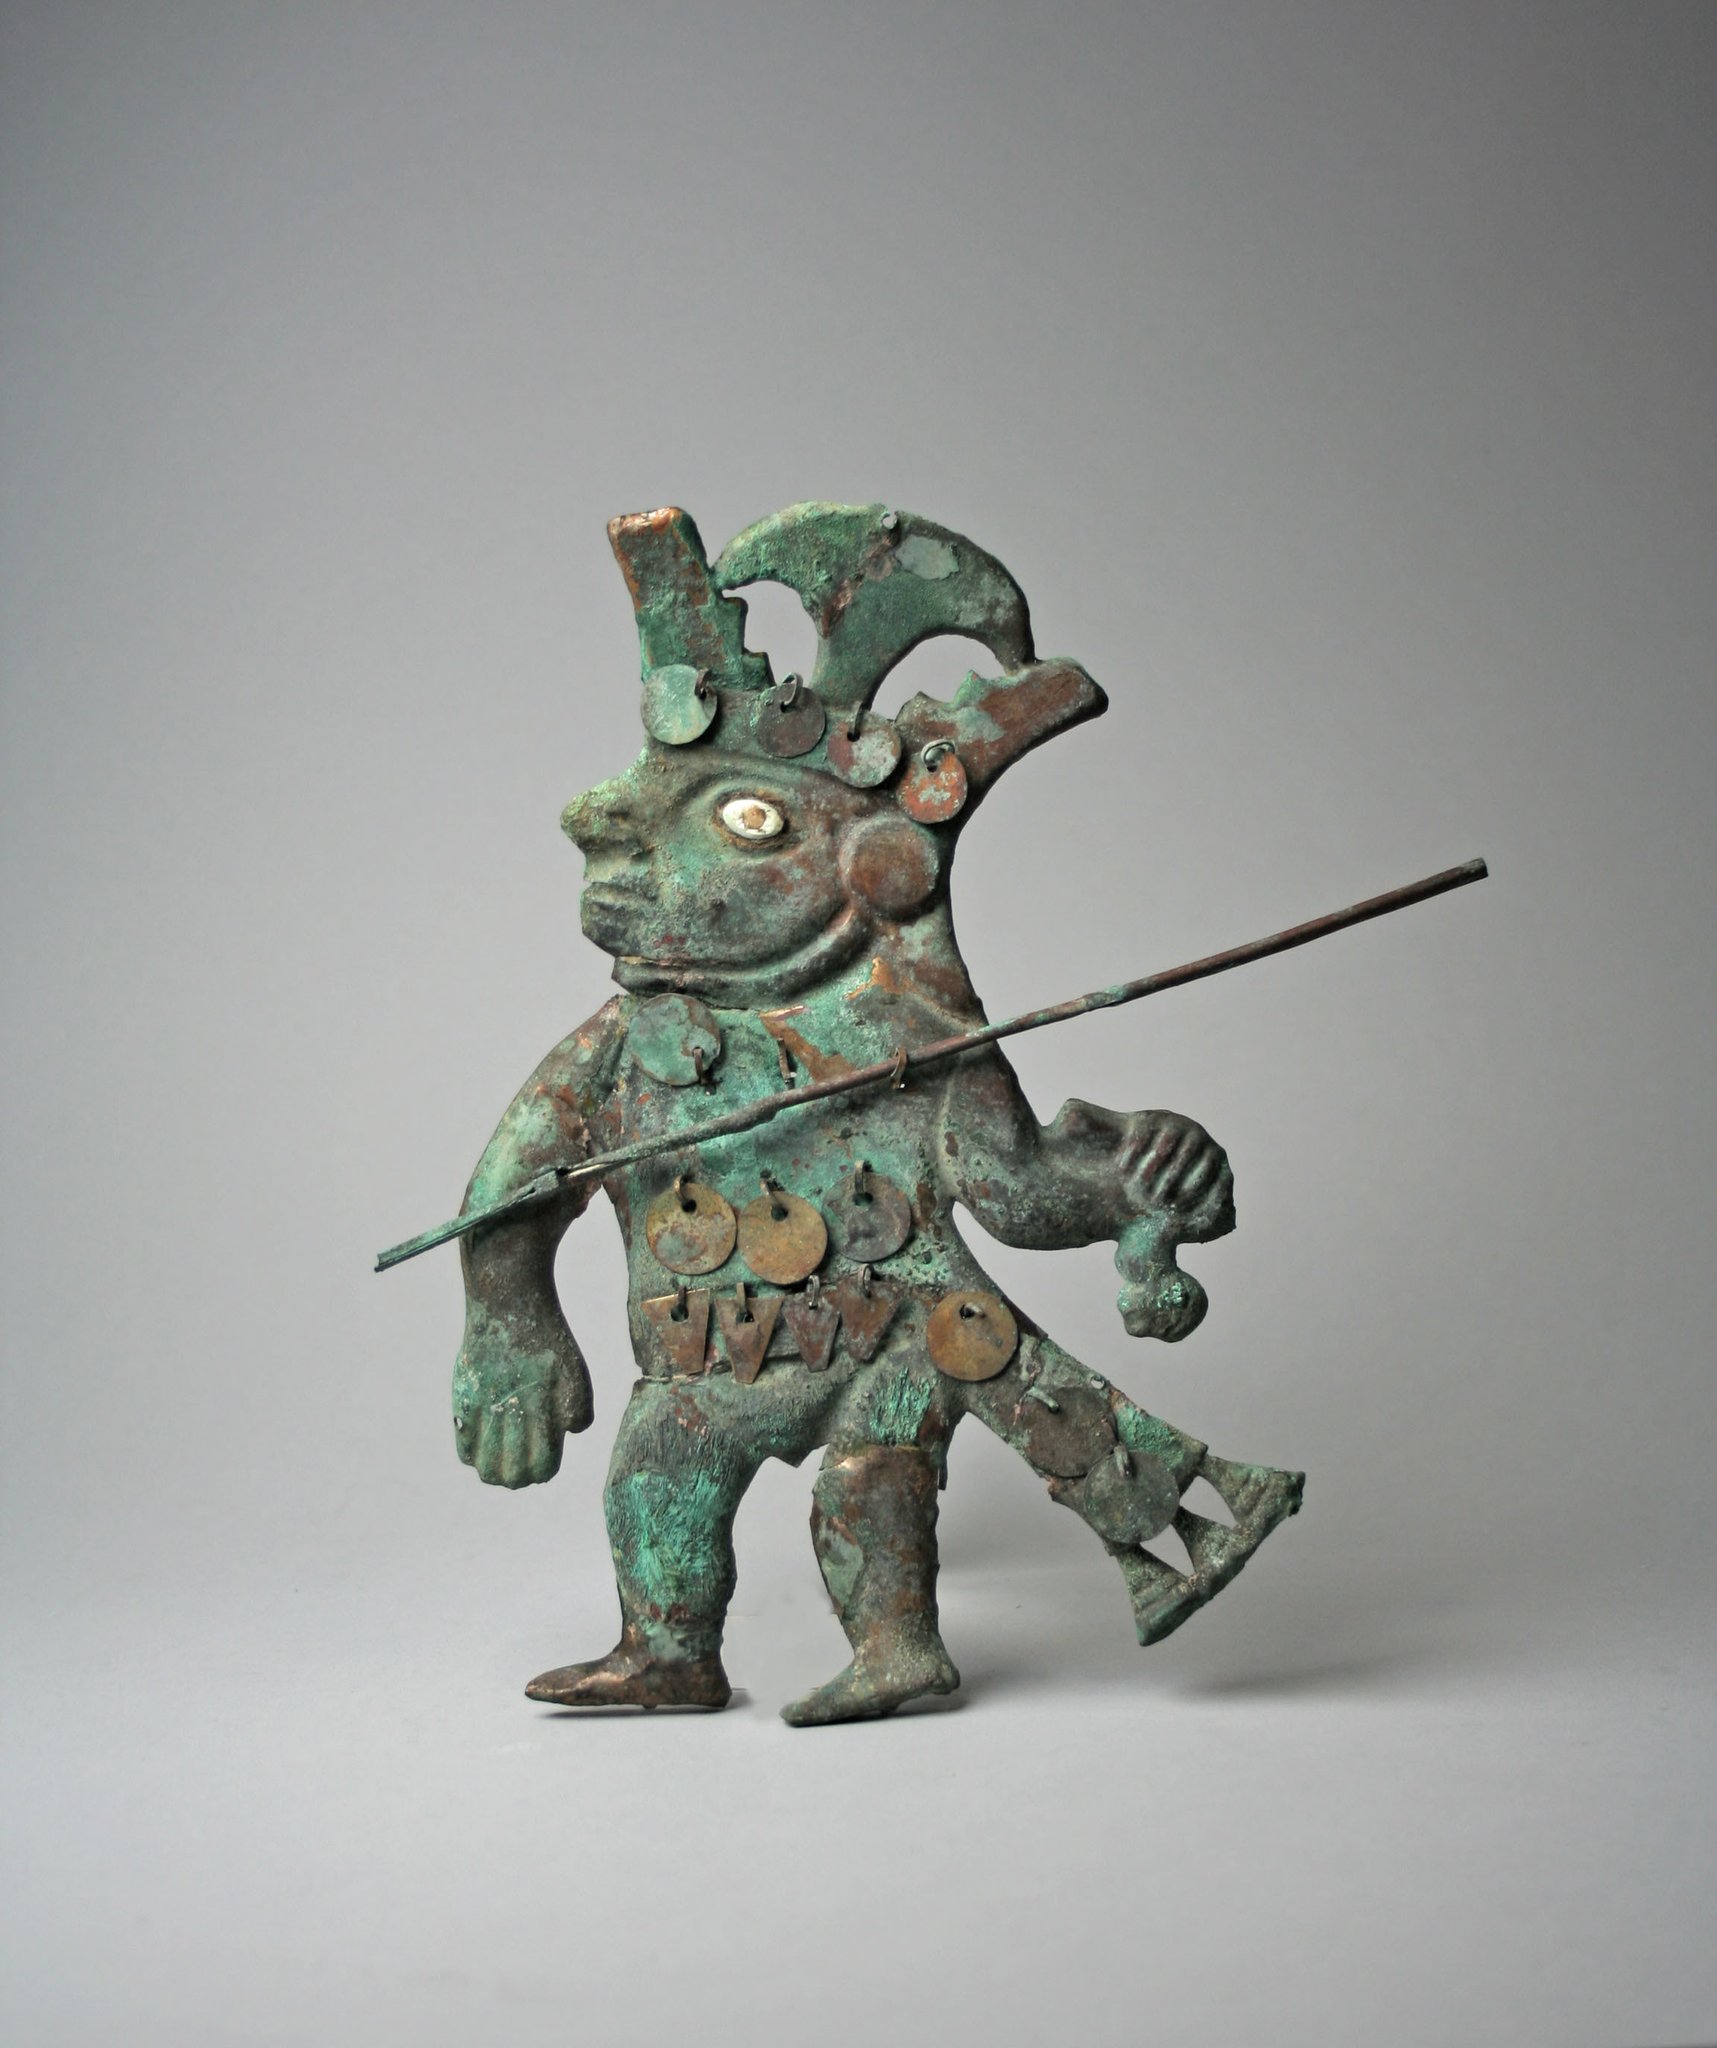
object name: ornament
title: Profile Warrior Ornament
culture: moche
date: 501-700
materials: gilt copper, shell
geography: peru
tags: weapons,men